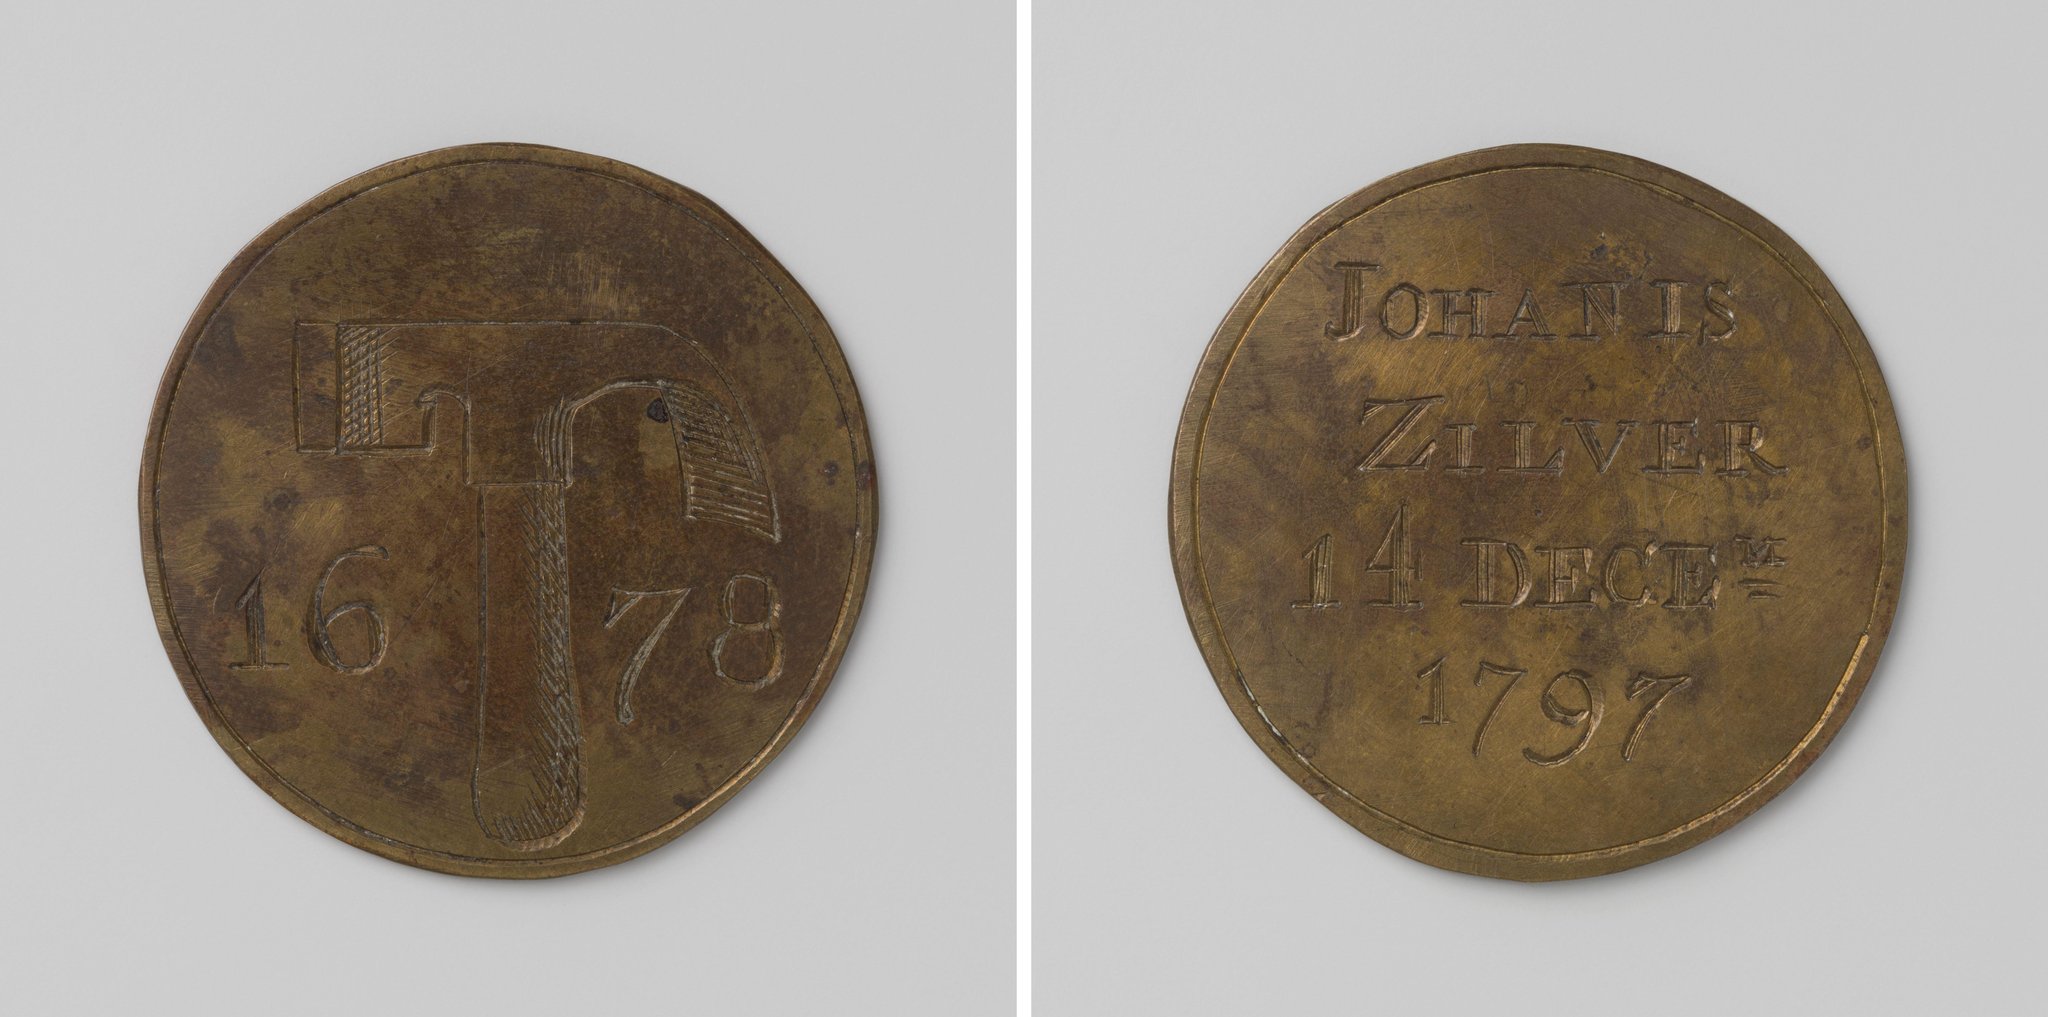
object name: medal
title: Kuipersgilde van Utrecht, gildepenning van Johanis Zilver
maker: Anonymous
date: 1797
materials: brass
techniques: engraving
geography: utrecht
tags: utrecht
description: Messing penning. Voorzijde: kuipershamer tussen jaartal 1678. Keerzijde: opschrift